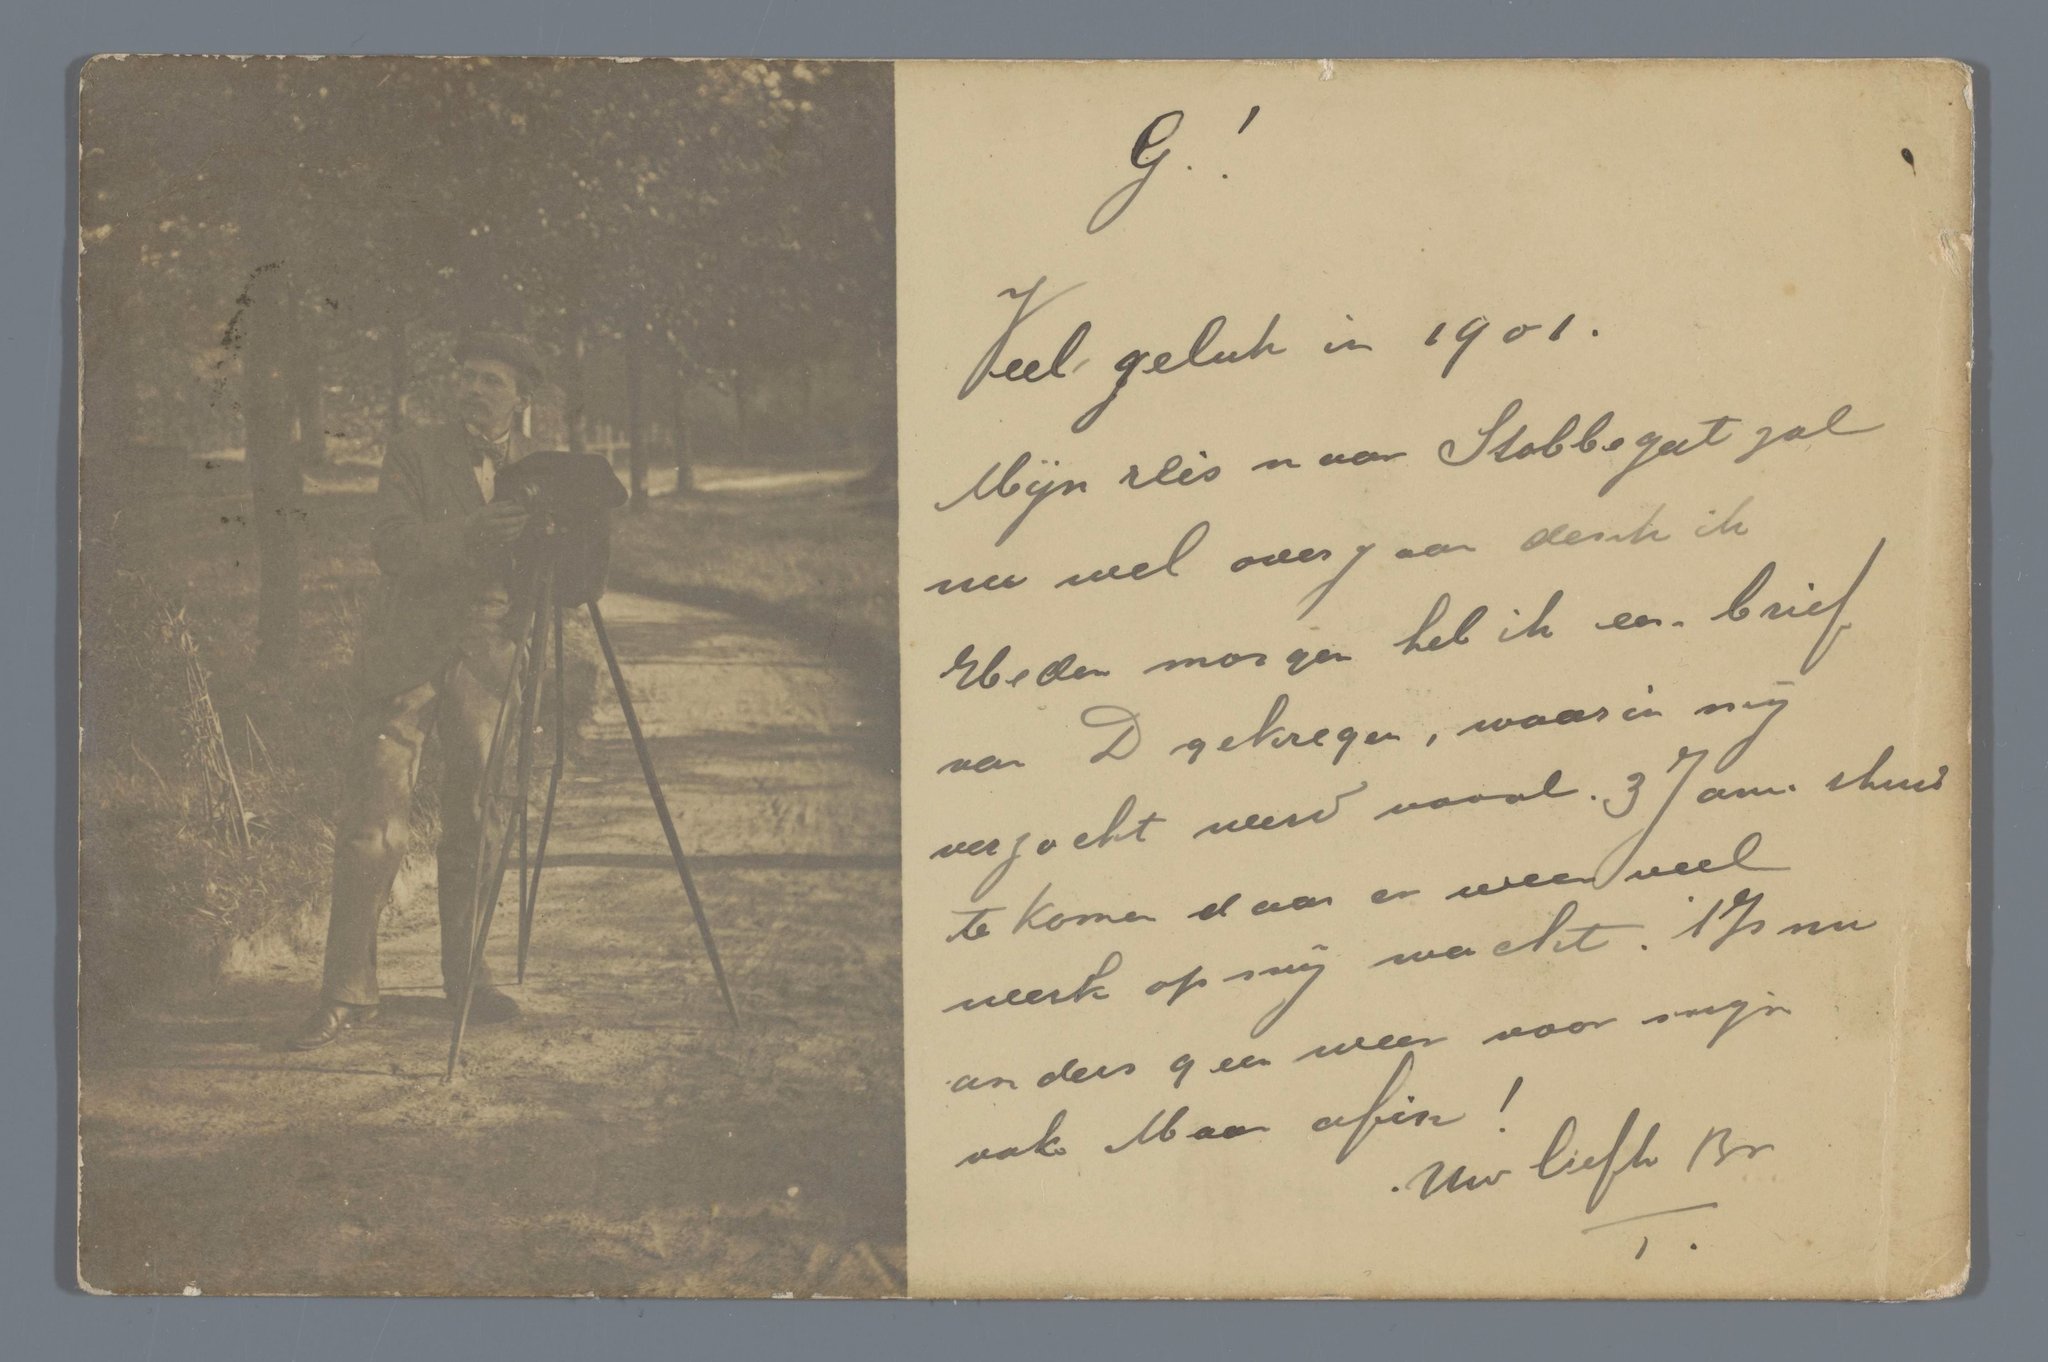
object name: ansichtkaart, prentbriefkaart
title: Fotograaf aan het werk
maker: jan adriani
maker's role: fotograaf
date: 1900-1949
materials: paper, photographic support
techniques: gelatin silver print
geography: netherlands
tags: photographer at work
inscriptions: annotation: ‘G.! / Veel geluk in 1901. / Mijn reis naar Slobbegat zal / nu wel overgaan denk ik / [etc.]’, inscription: ‘Briefkaart’, name: ‘den Heer K. Hoekstra / Iba s (?) / Slobbegat (Fr)’